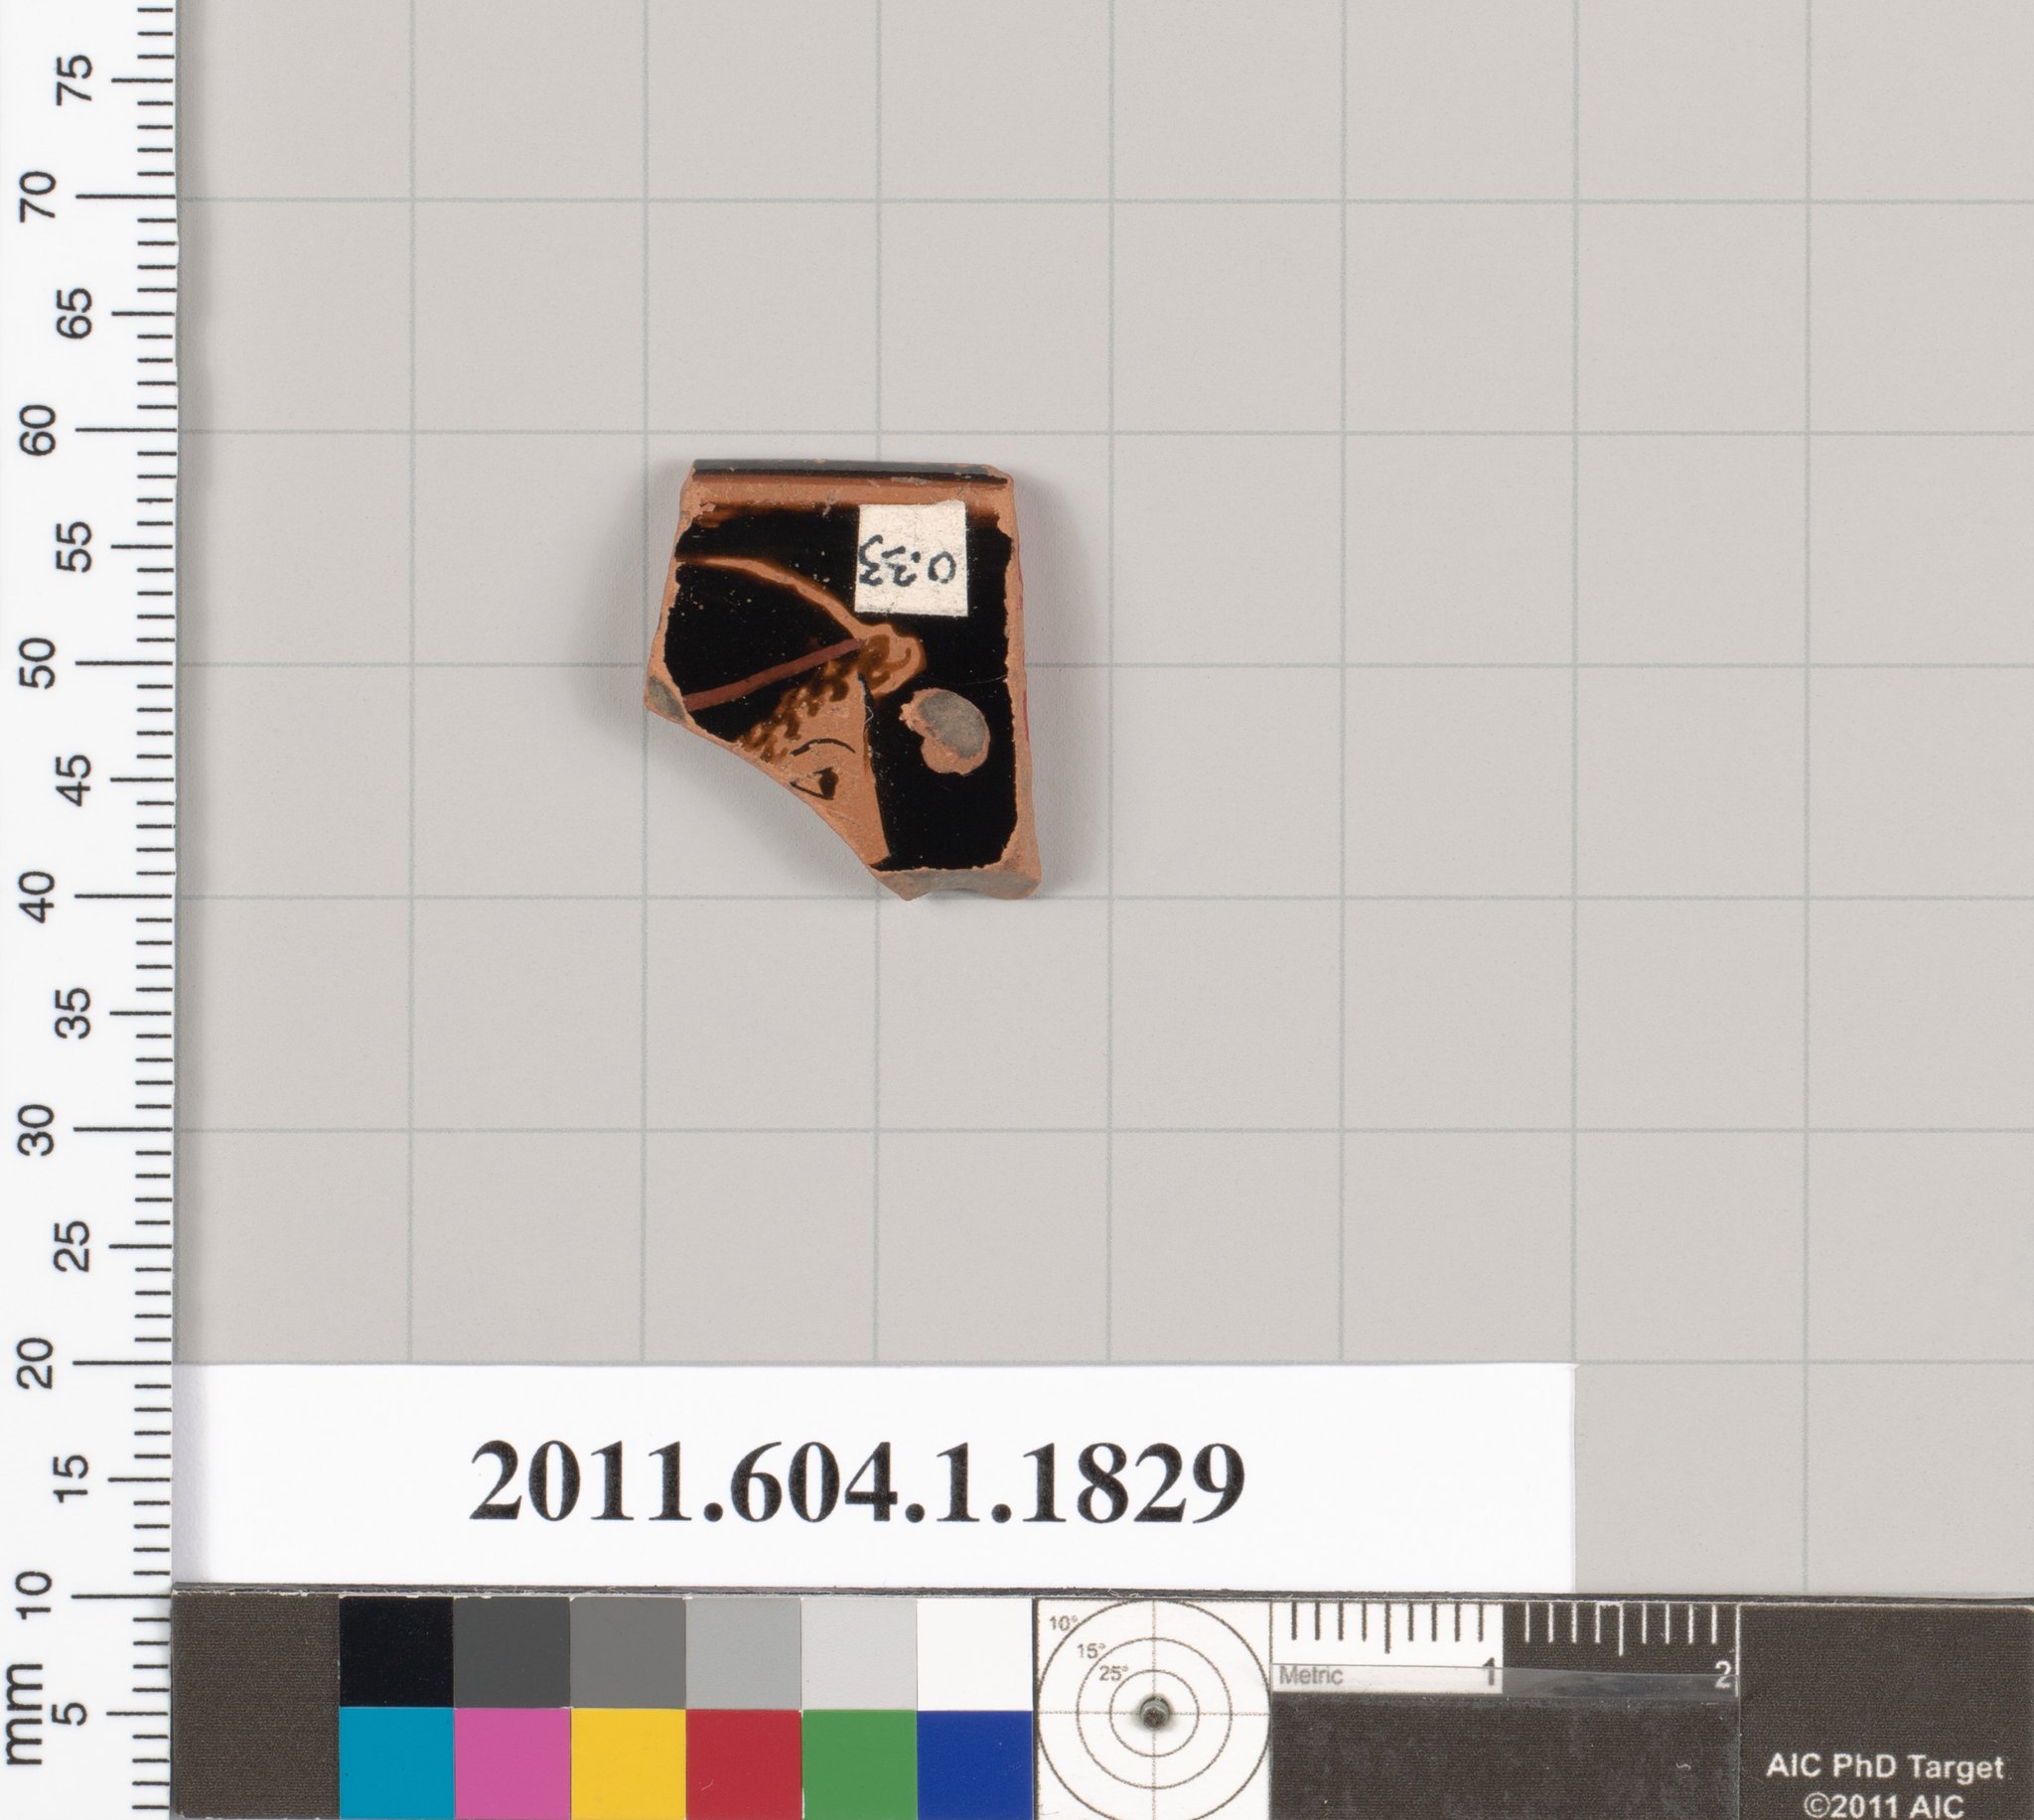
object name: kylix fragment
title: Terracotta rim fragment of a kylix (drinking cup)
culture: greek, attic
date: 460-450 BCE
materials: terracotta